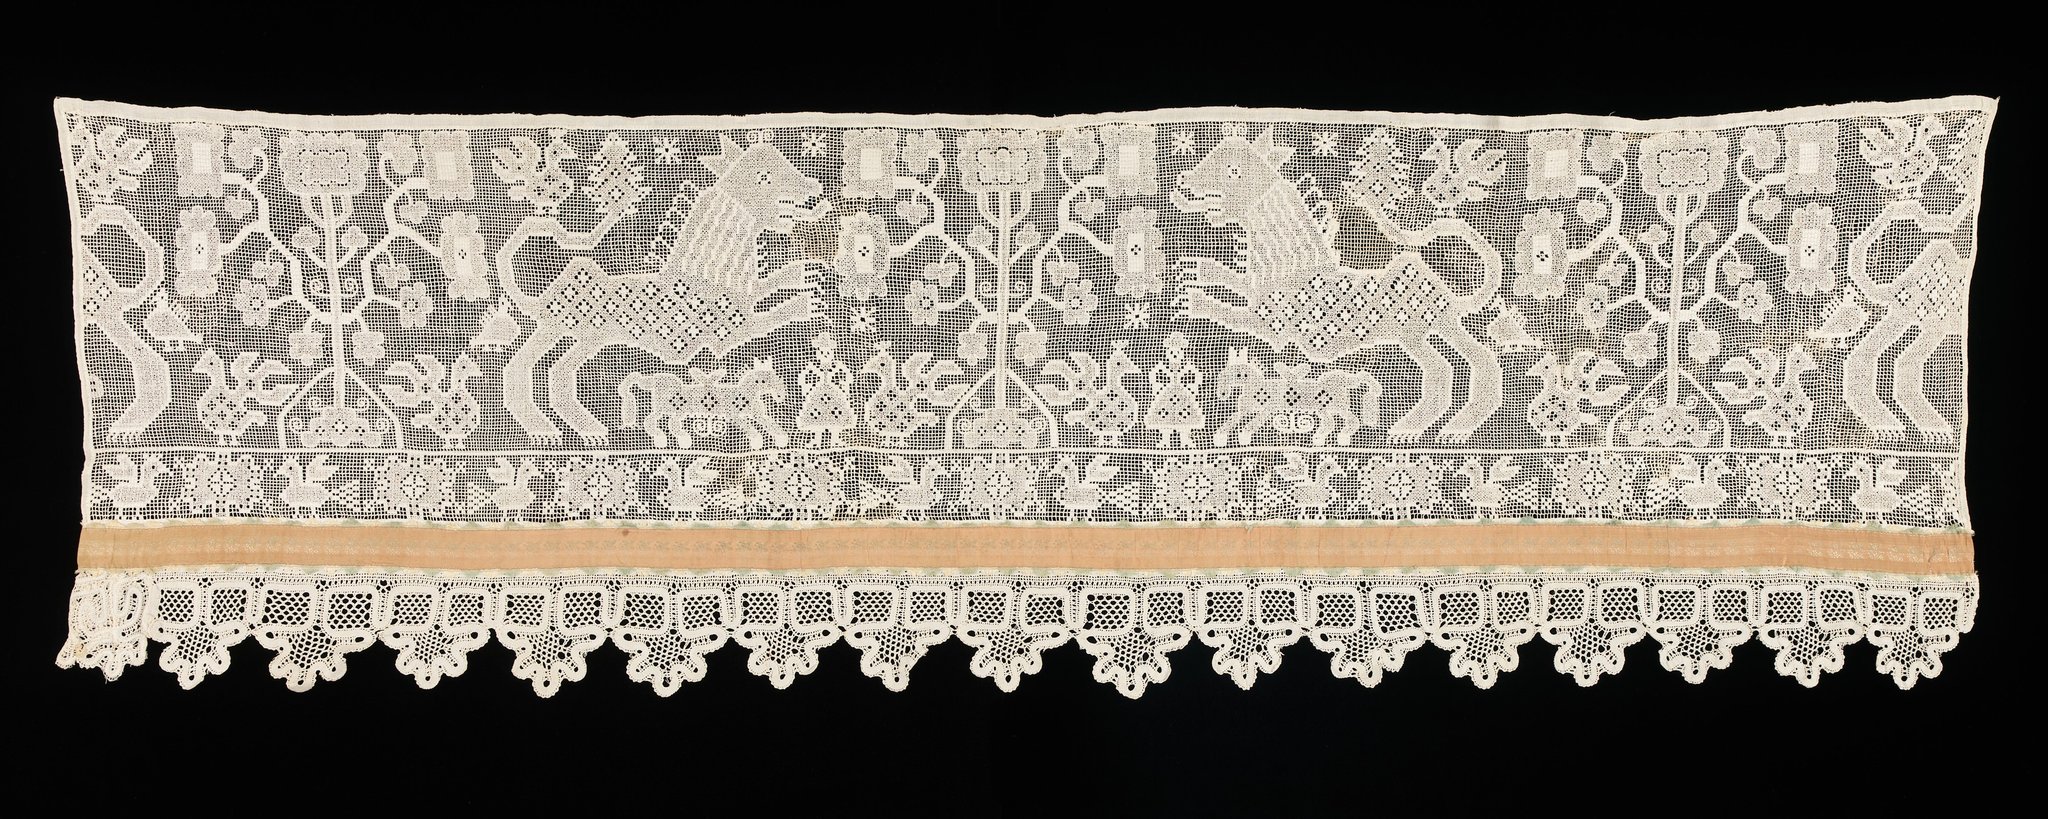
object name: border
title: Bed curtain border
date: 1801-1833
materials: linen, silk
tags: birds,horses,lions